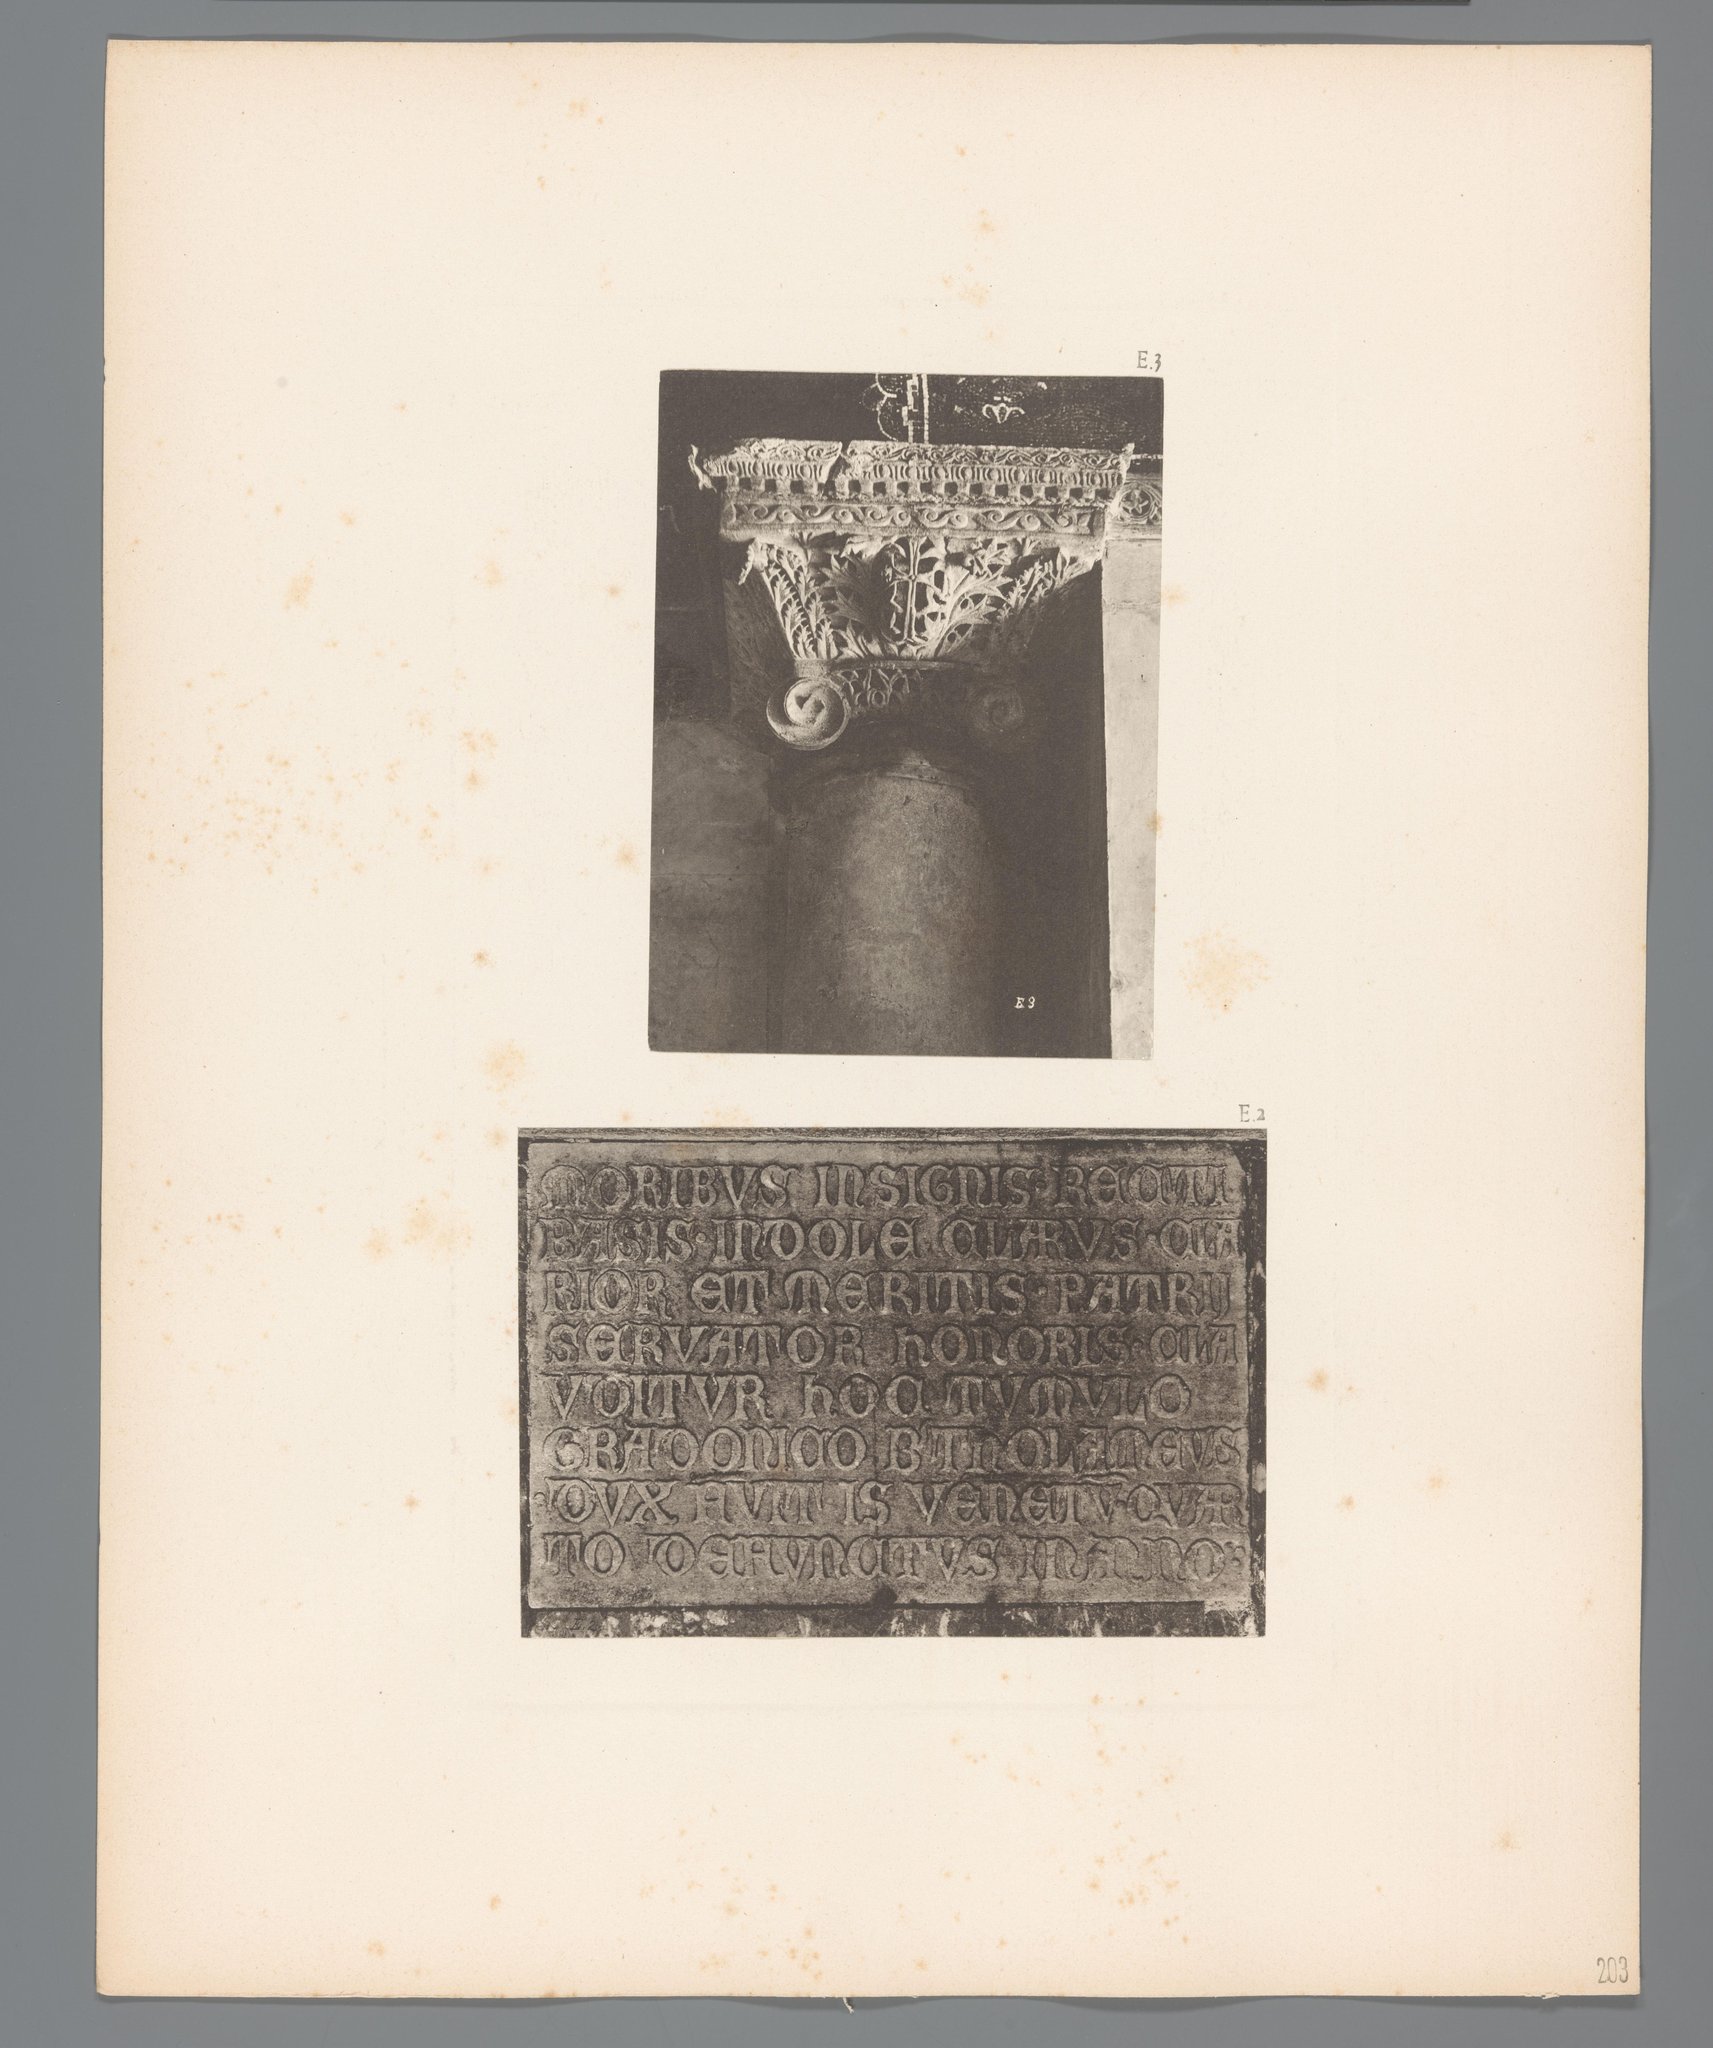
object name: photomechanical print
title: Korinthische zuil en een inscriptie van de San Marco in Venetië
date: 1880-1885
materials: paper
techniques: photograph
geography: venice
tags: inscription, capital (~ column, pillar) (+ classical art), corinthian order ~ architecture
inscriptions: number: ‘E.2’, number: ‘E.2.’, number: ‘E.3’, number: ‘203’, number: ‘E 3’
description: Deze prenten maken deel uit van een omslag met 79 prenten op 53 bladen en 2 tekstbladen.